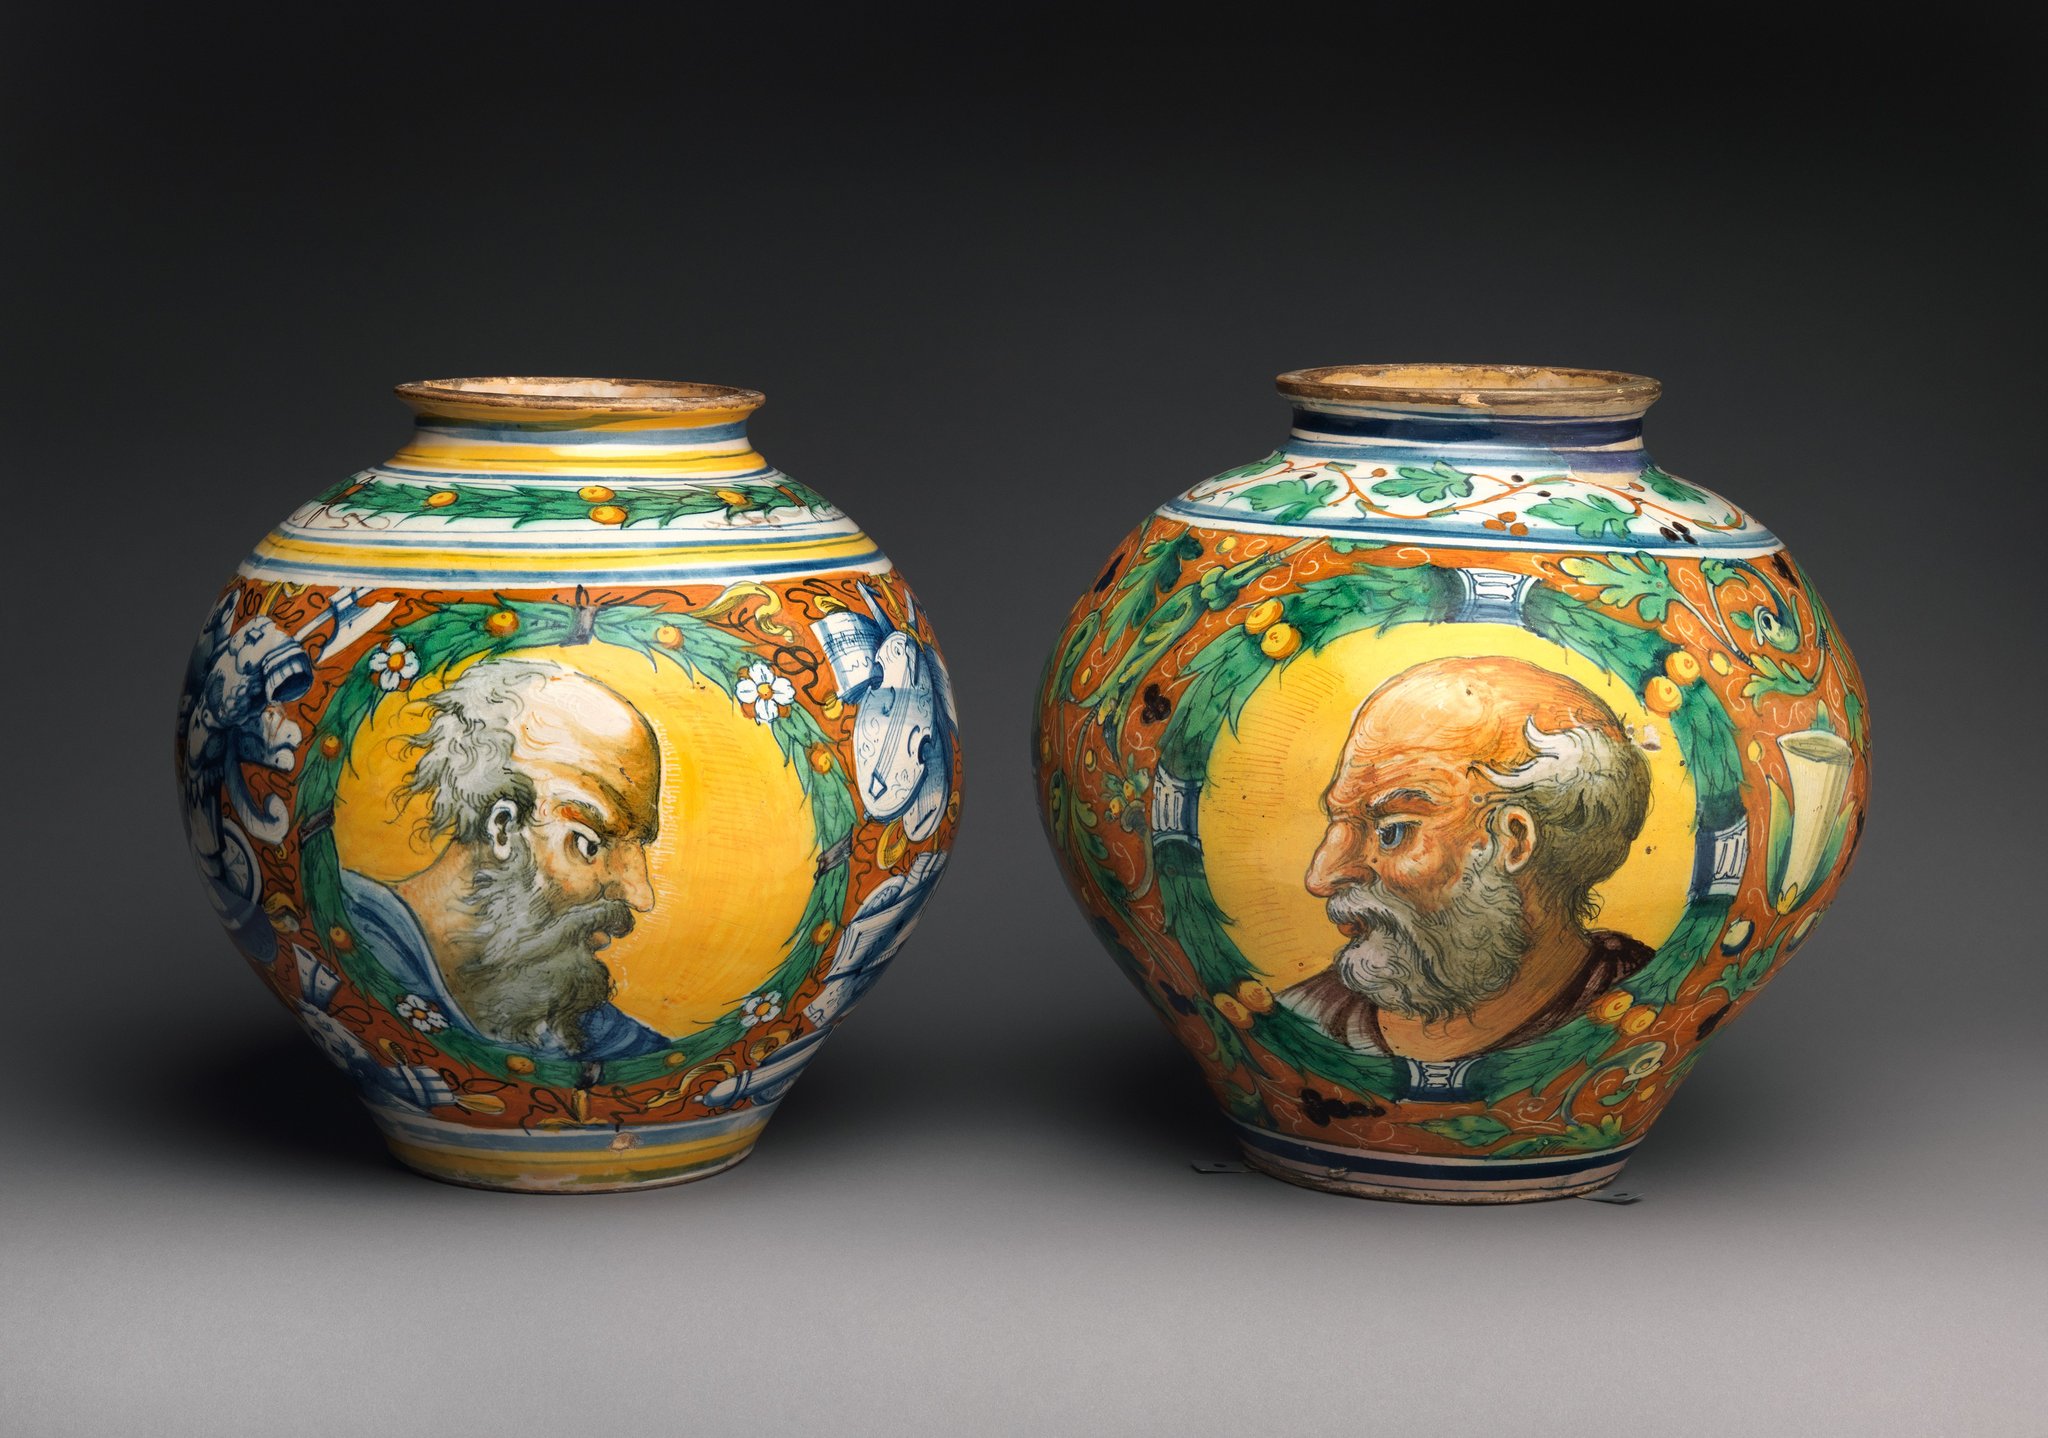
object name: storage jar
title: Storage jar (one of a pair)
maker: domenico veneziano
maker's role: maker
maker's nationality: italian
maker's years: 1438-1461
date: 1550-1570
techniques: maiolica, glazing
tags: men,women,horses